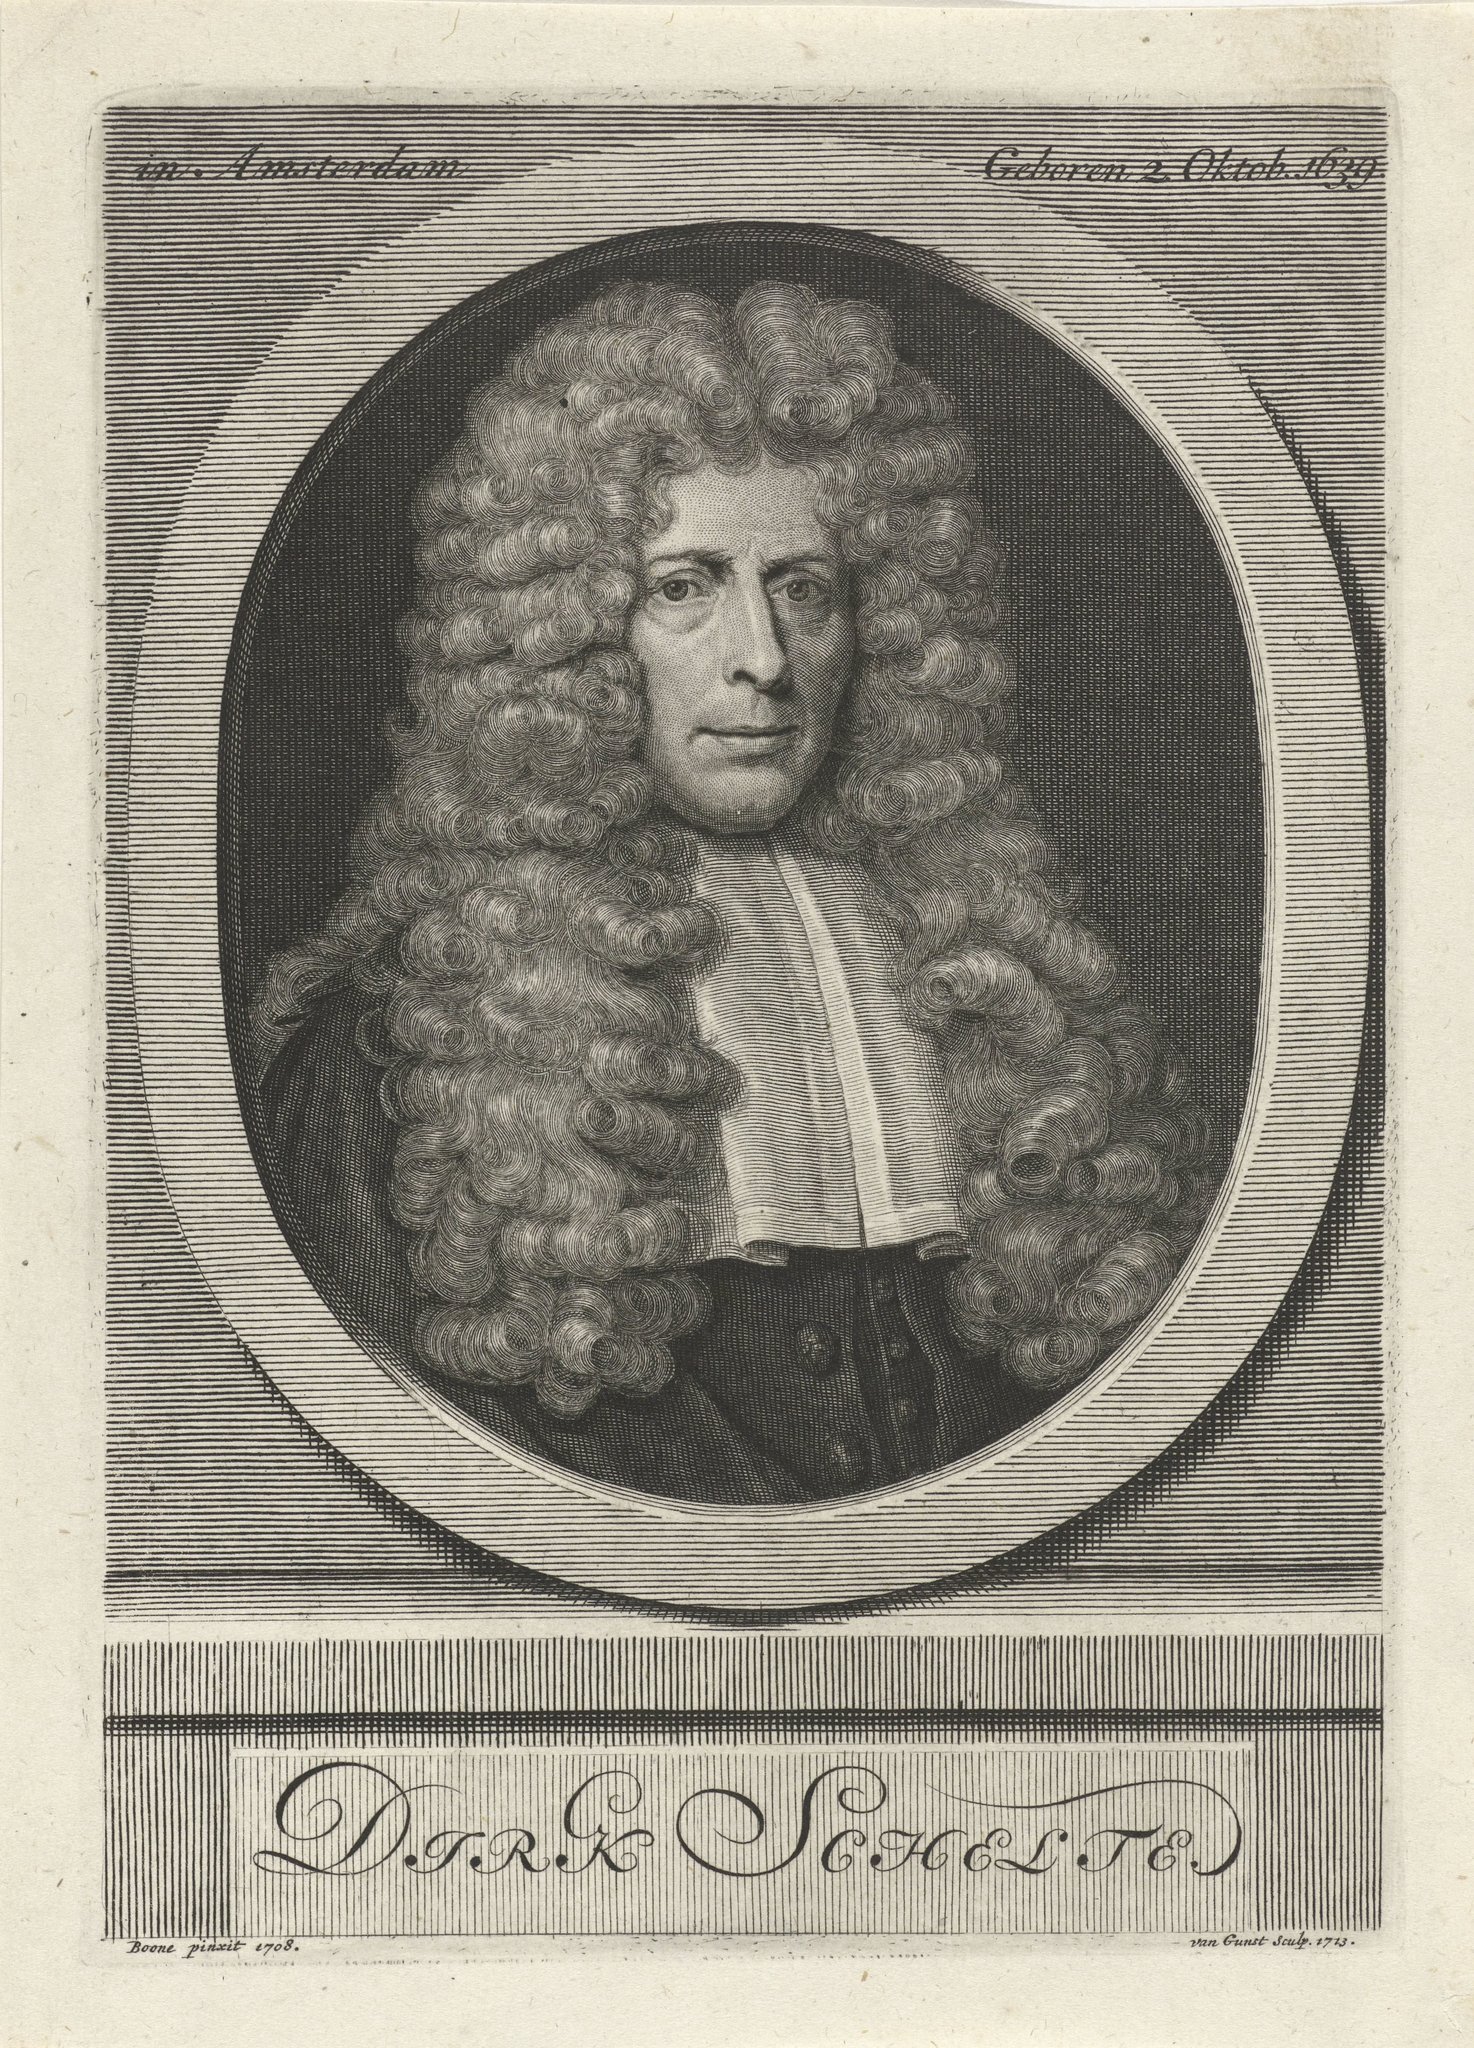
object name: print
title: Portret van Dirk Schelte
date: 1713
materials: paper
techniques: engraving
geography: amsterdam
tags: dirk schelte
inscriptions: collector's mark: Lugt 2228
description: Dirk Schelte, Amsterdamse juwelier, diaken en burleske dichter.